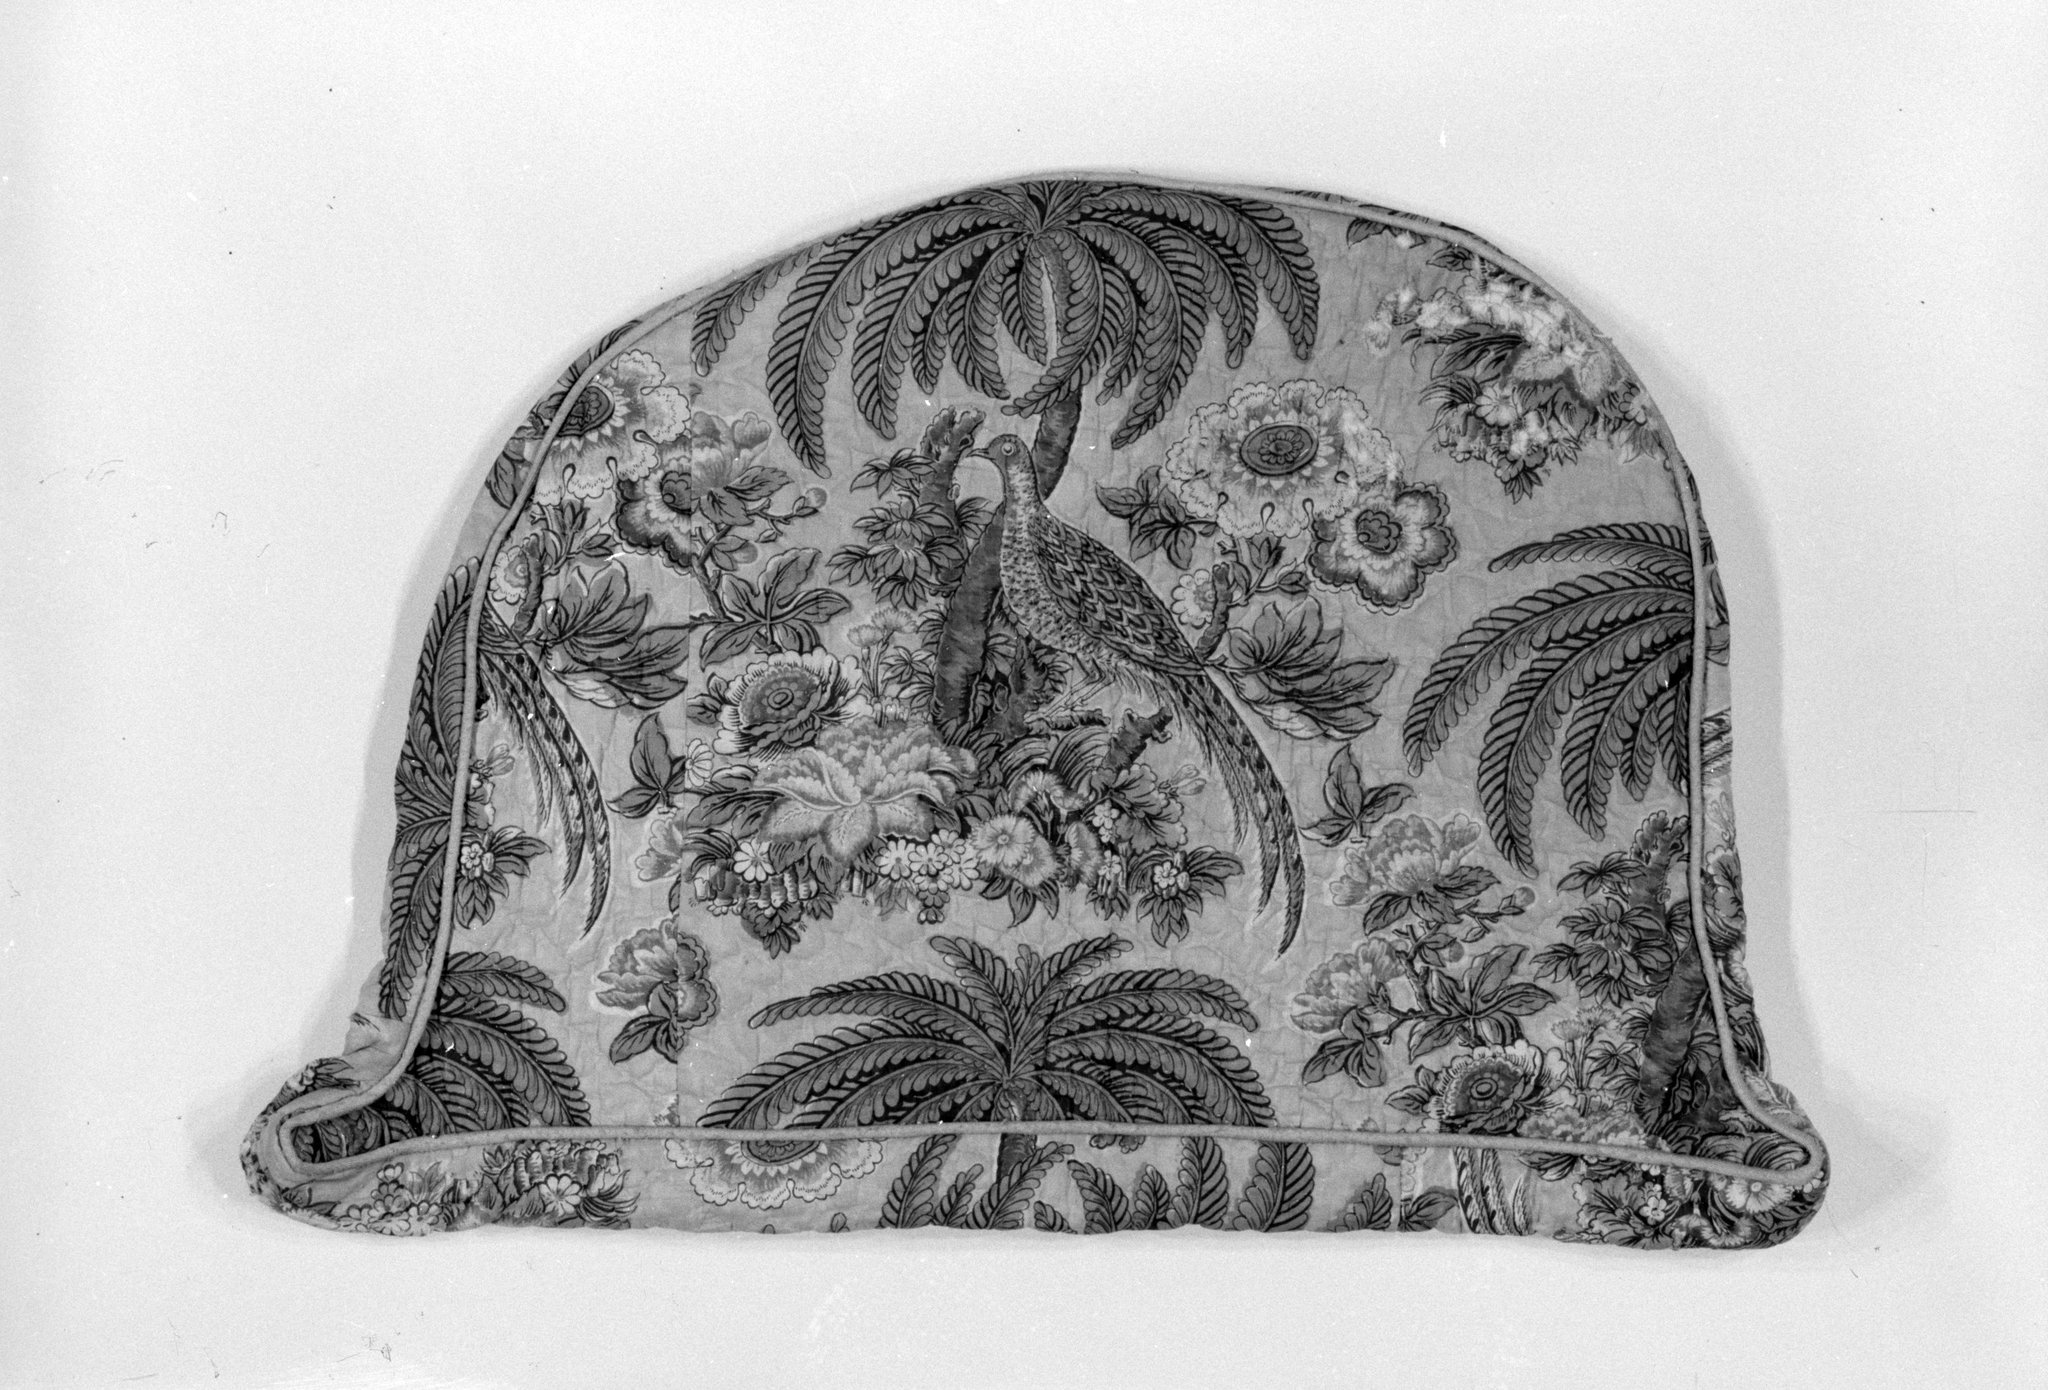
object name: printed piece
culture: british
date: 1830-1835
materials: cotton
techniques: printing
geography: england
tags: birds,flowers,trees